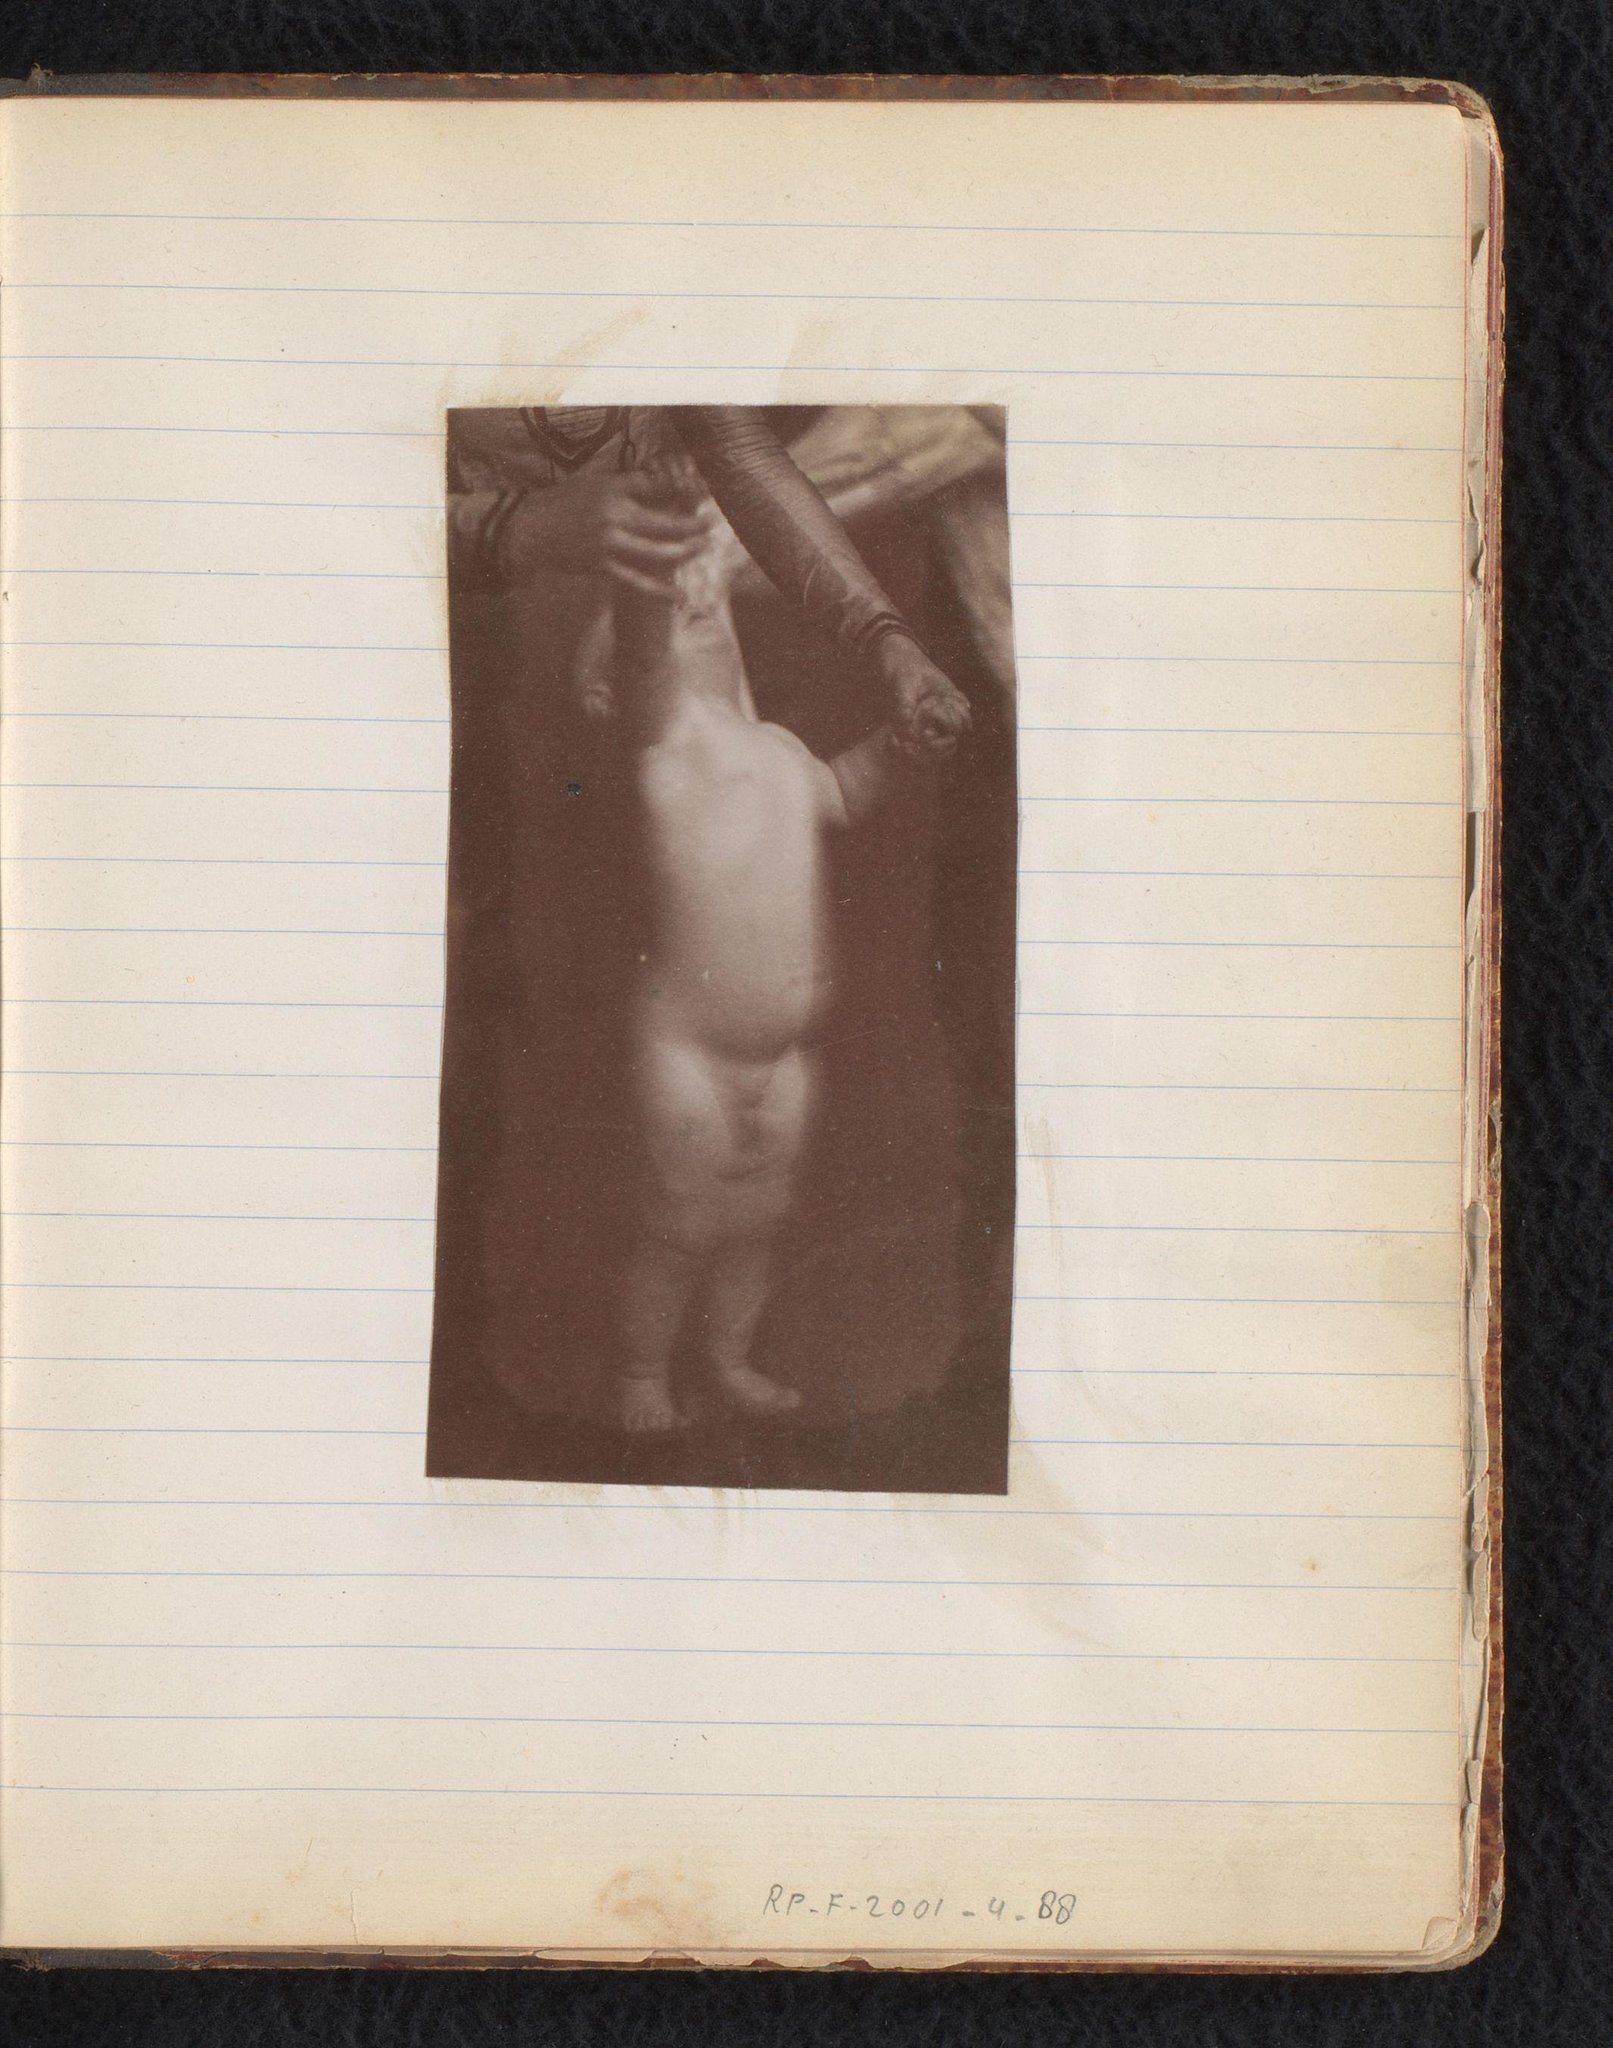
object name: album leaf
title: Studie van een naakte peuter en vrouw, door Jacques de Lalaing, voorstudie voor Heilige Maagd met het kind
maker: jacques lalaing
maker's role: painter, sculptor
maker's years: 1858-1917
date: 1900-1914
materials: paper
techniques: albumen print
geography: brussels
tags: the (nude) human figure; 'corpo humano' (ripa), infant, baby, artist (in general) working from nude model